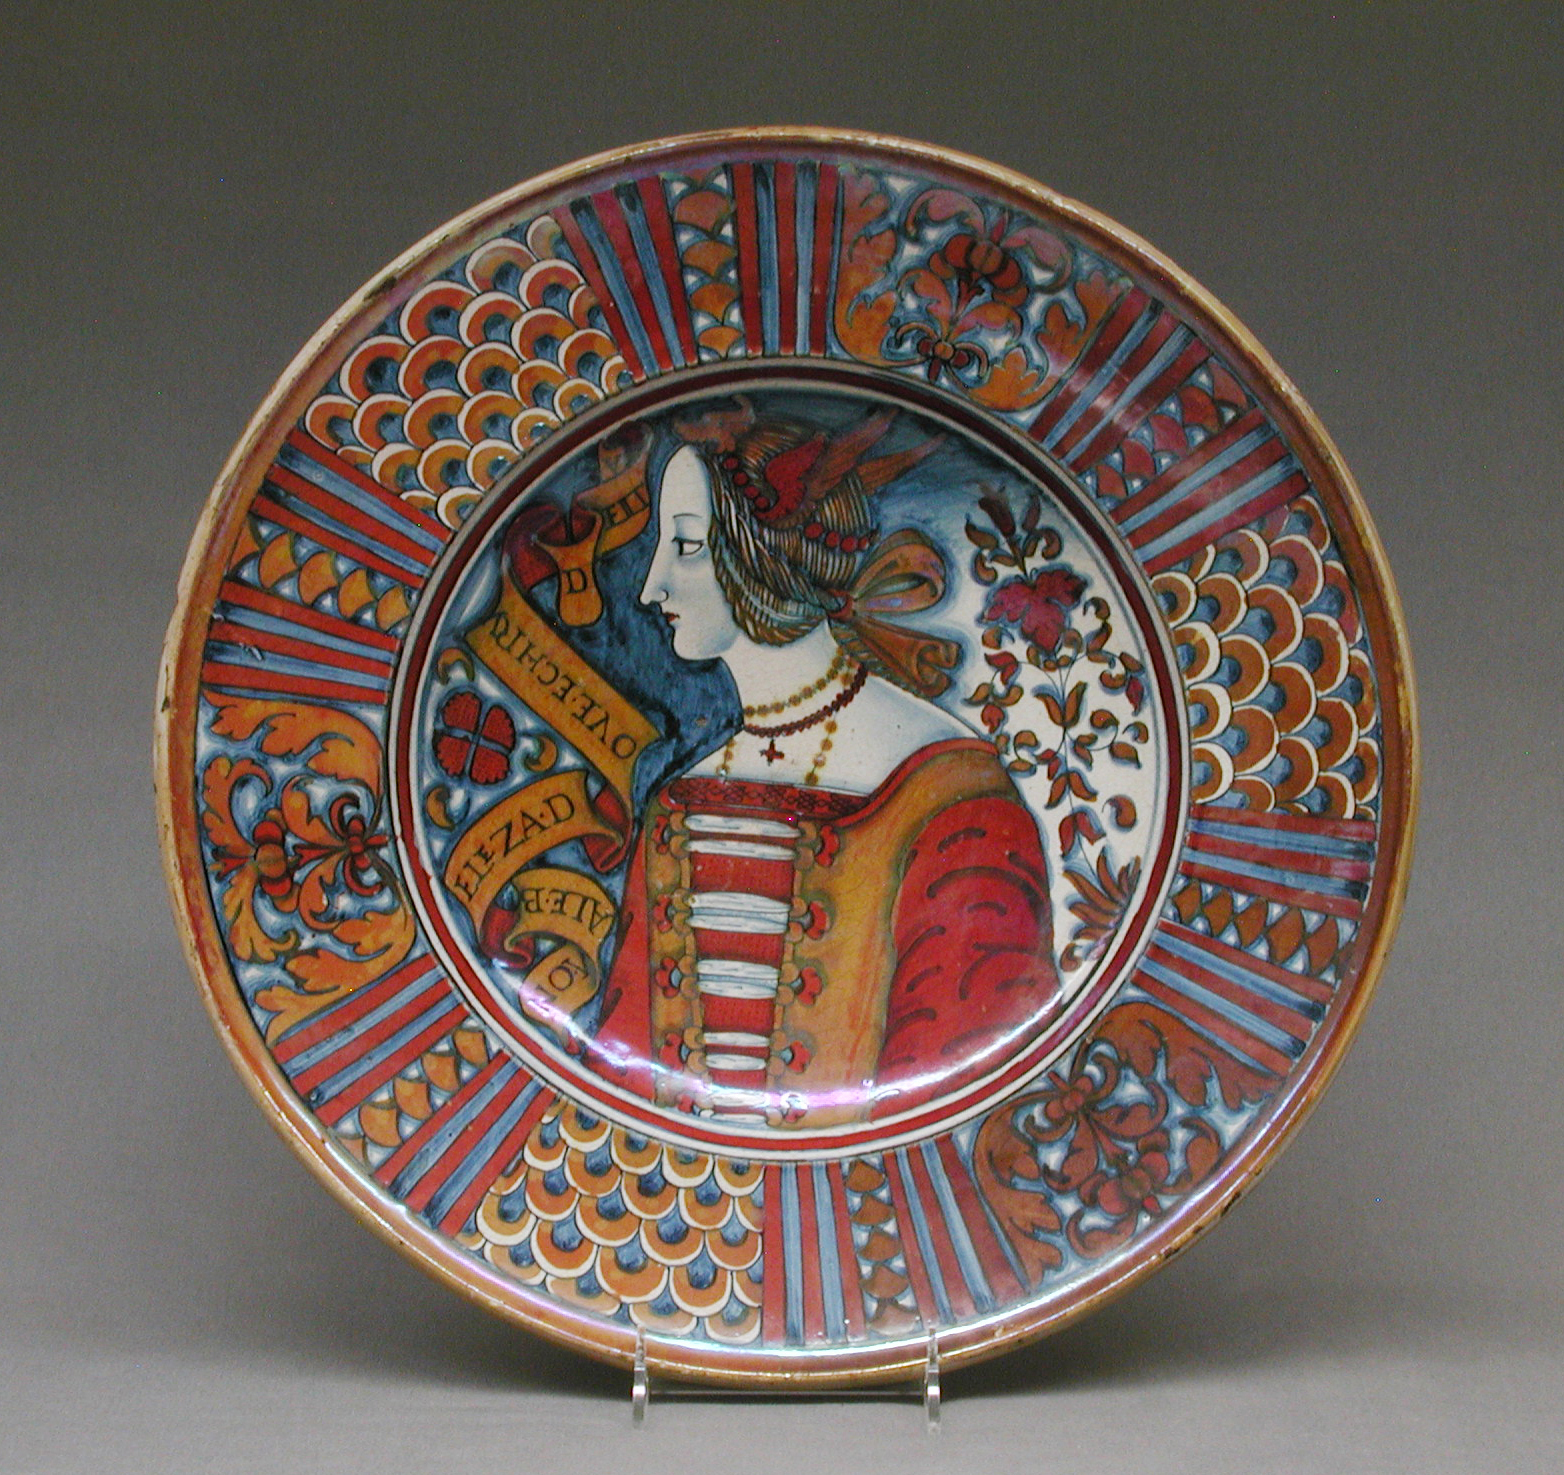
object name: dish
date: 1801-1900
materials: earthenware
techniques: glazing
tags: profiles,women,flowers